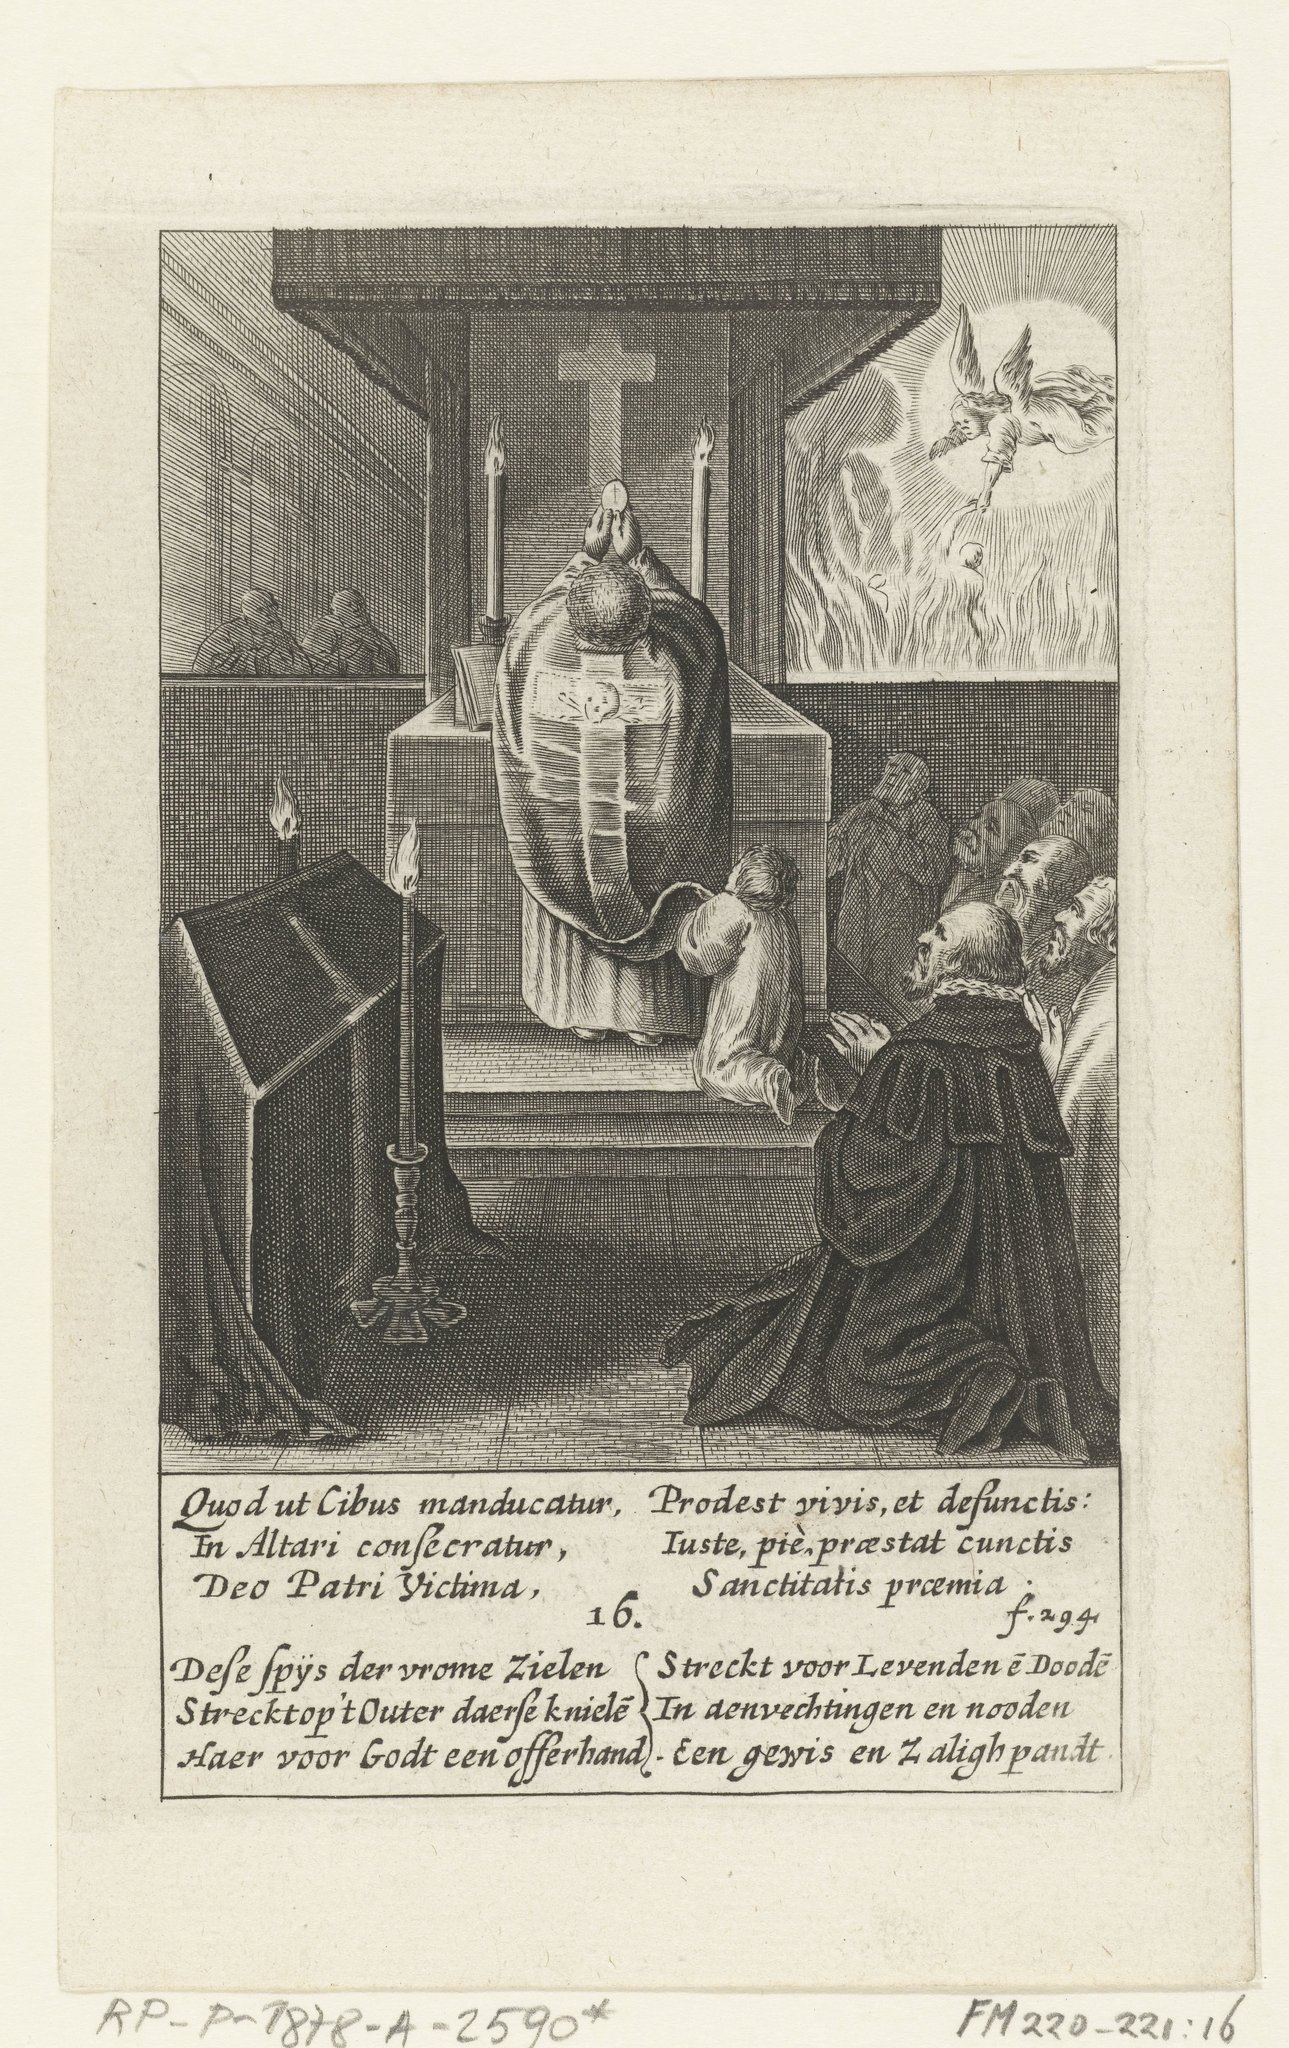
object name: print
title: De lijkdienst, 16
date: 1639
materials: paper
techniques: engraving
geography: southern netherlands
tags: office of the dead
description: De lijkdienst. De priester houdt het H. Sacrament omhoog. Rechts op de achtergrond redt een engel een ziel uit het vagevuur. Op de voorgrond links de doodskist onder een kleed, rechts knielende mannen. Prent nr. 16 uit de serie van 16 voorstellingen van Het Mirakel van Amsterdam, naar de gebeurtenissen op 15 maart 1345. Onder de voorstelling twee zesregelige verzen in het Latijn en Nederlands.